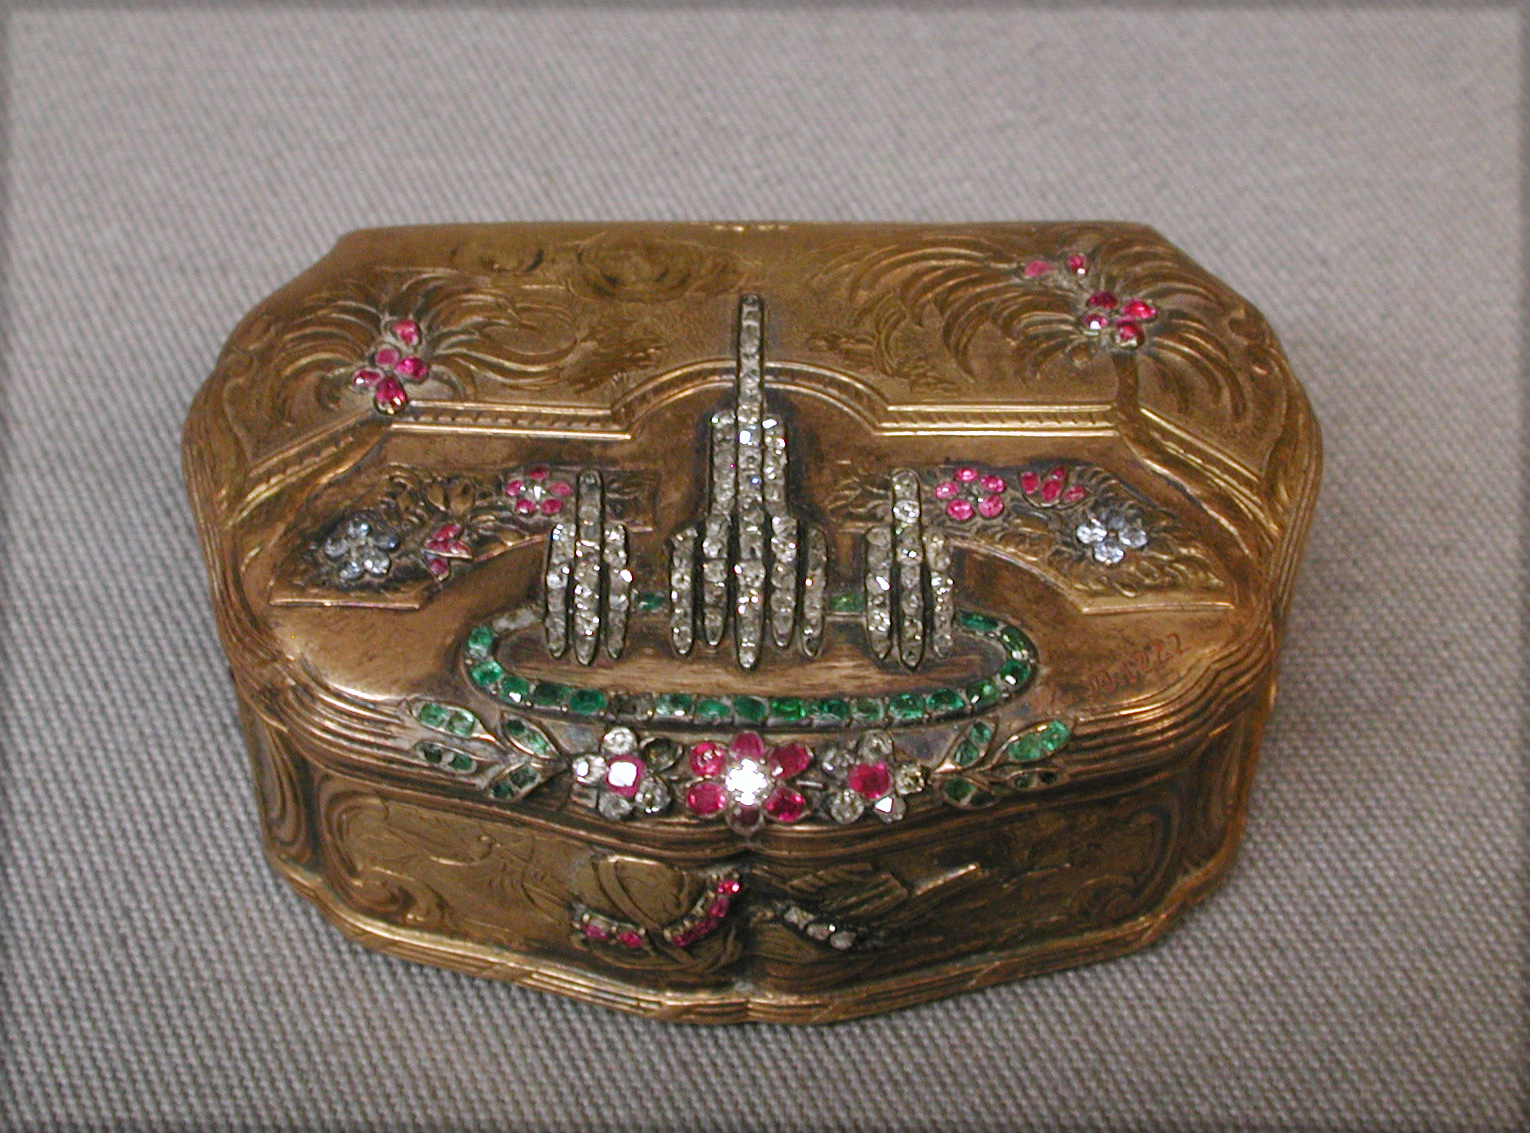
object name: box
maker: f.s.c. (or g)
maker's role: maker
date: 1750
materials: diamond, gemstone, gold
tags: flowers